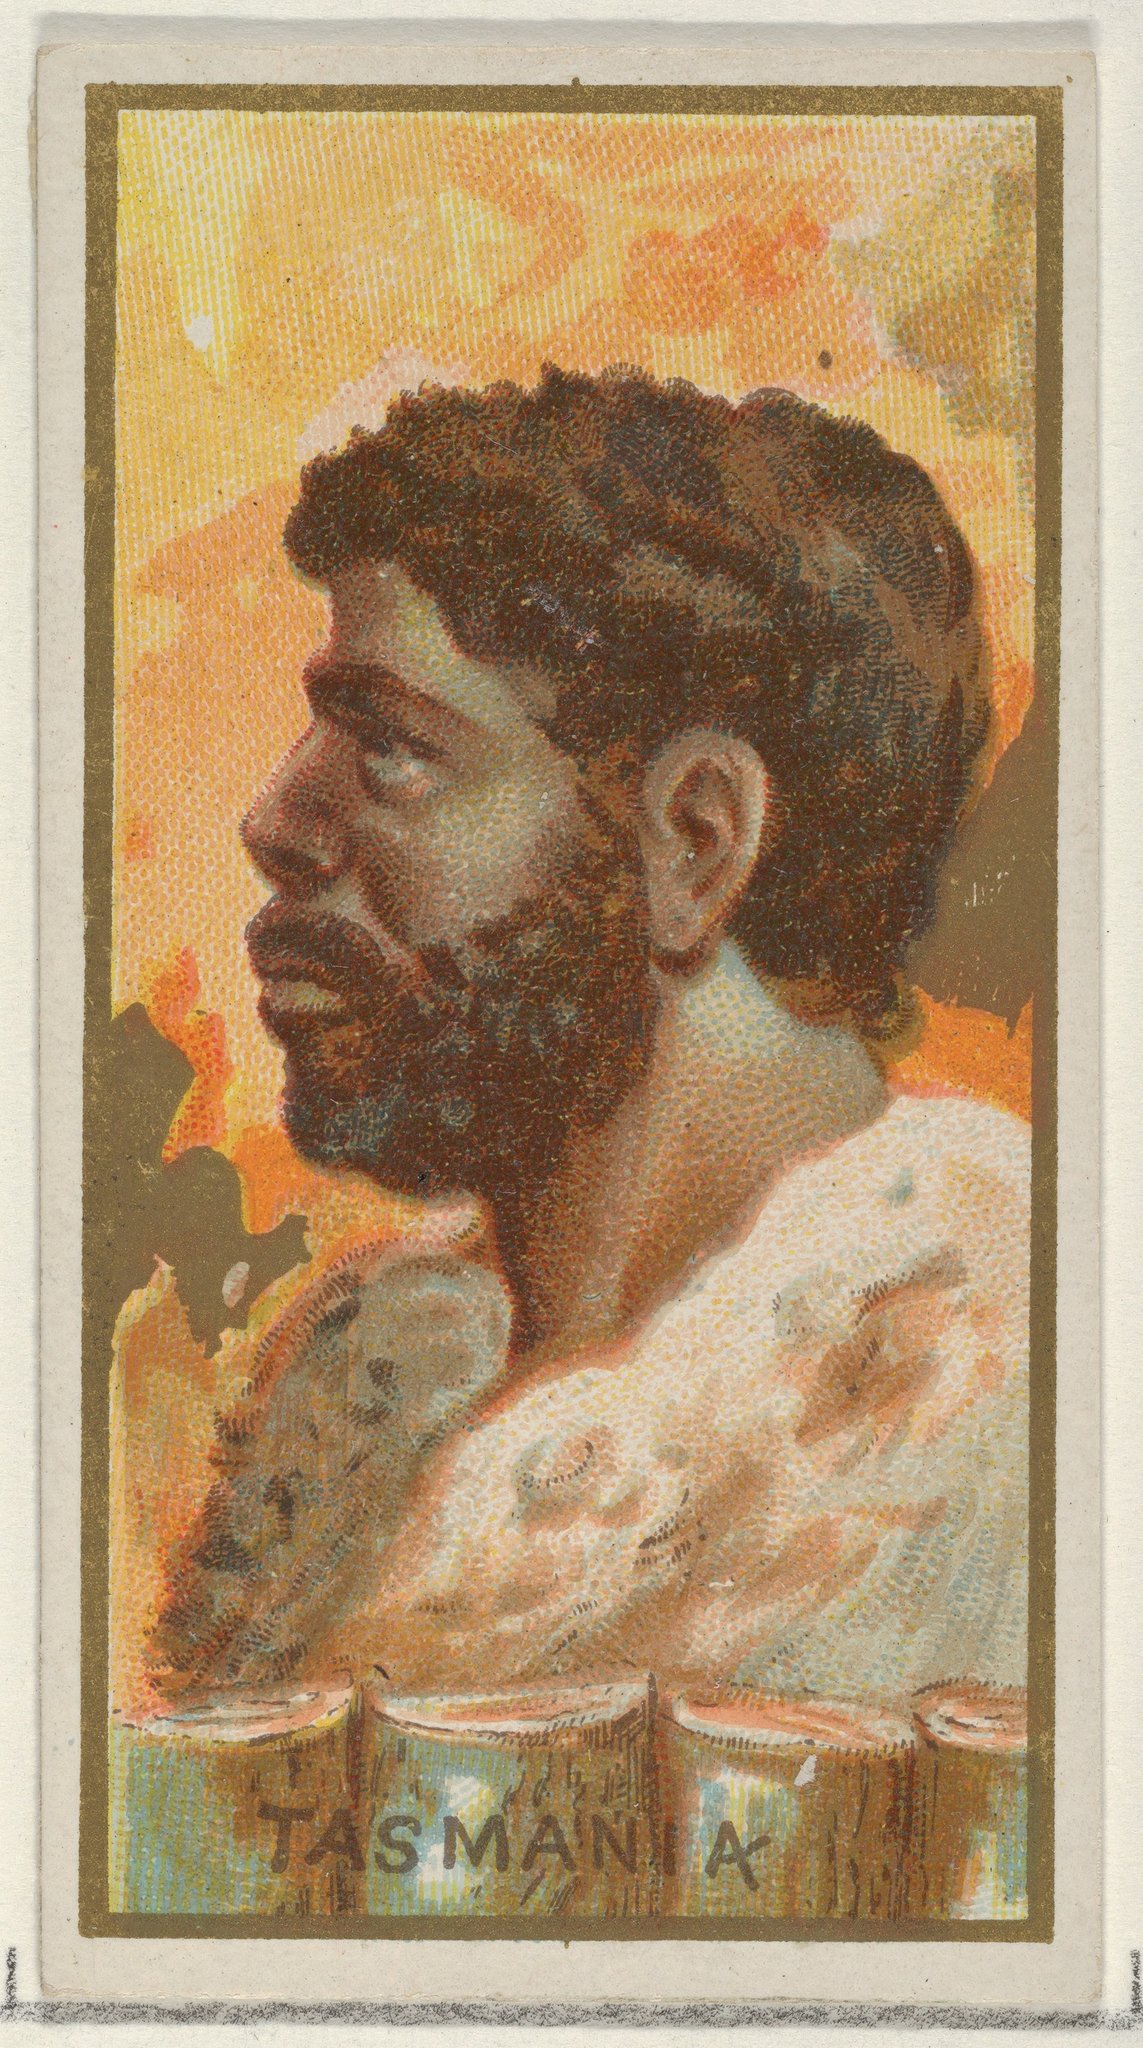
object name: print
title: Tasmania, from the Types of All Nations series (N24) for Allen & Ginter Cigarettes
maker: allen & ginter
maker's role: publisher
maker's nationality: american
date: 1889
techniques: color lithograph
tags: men,profiles